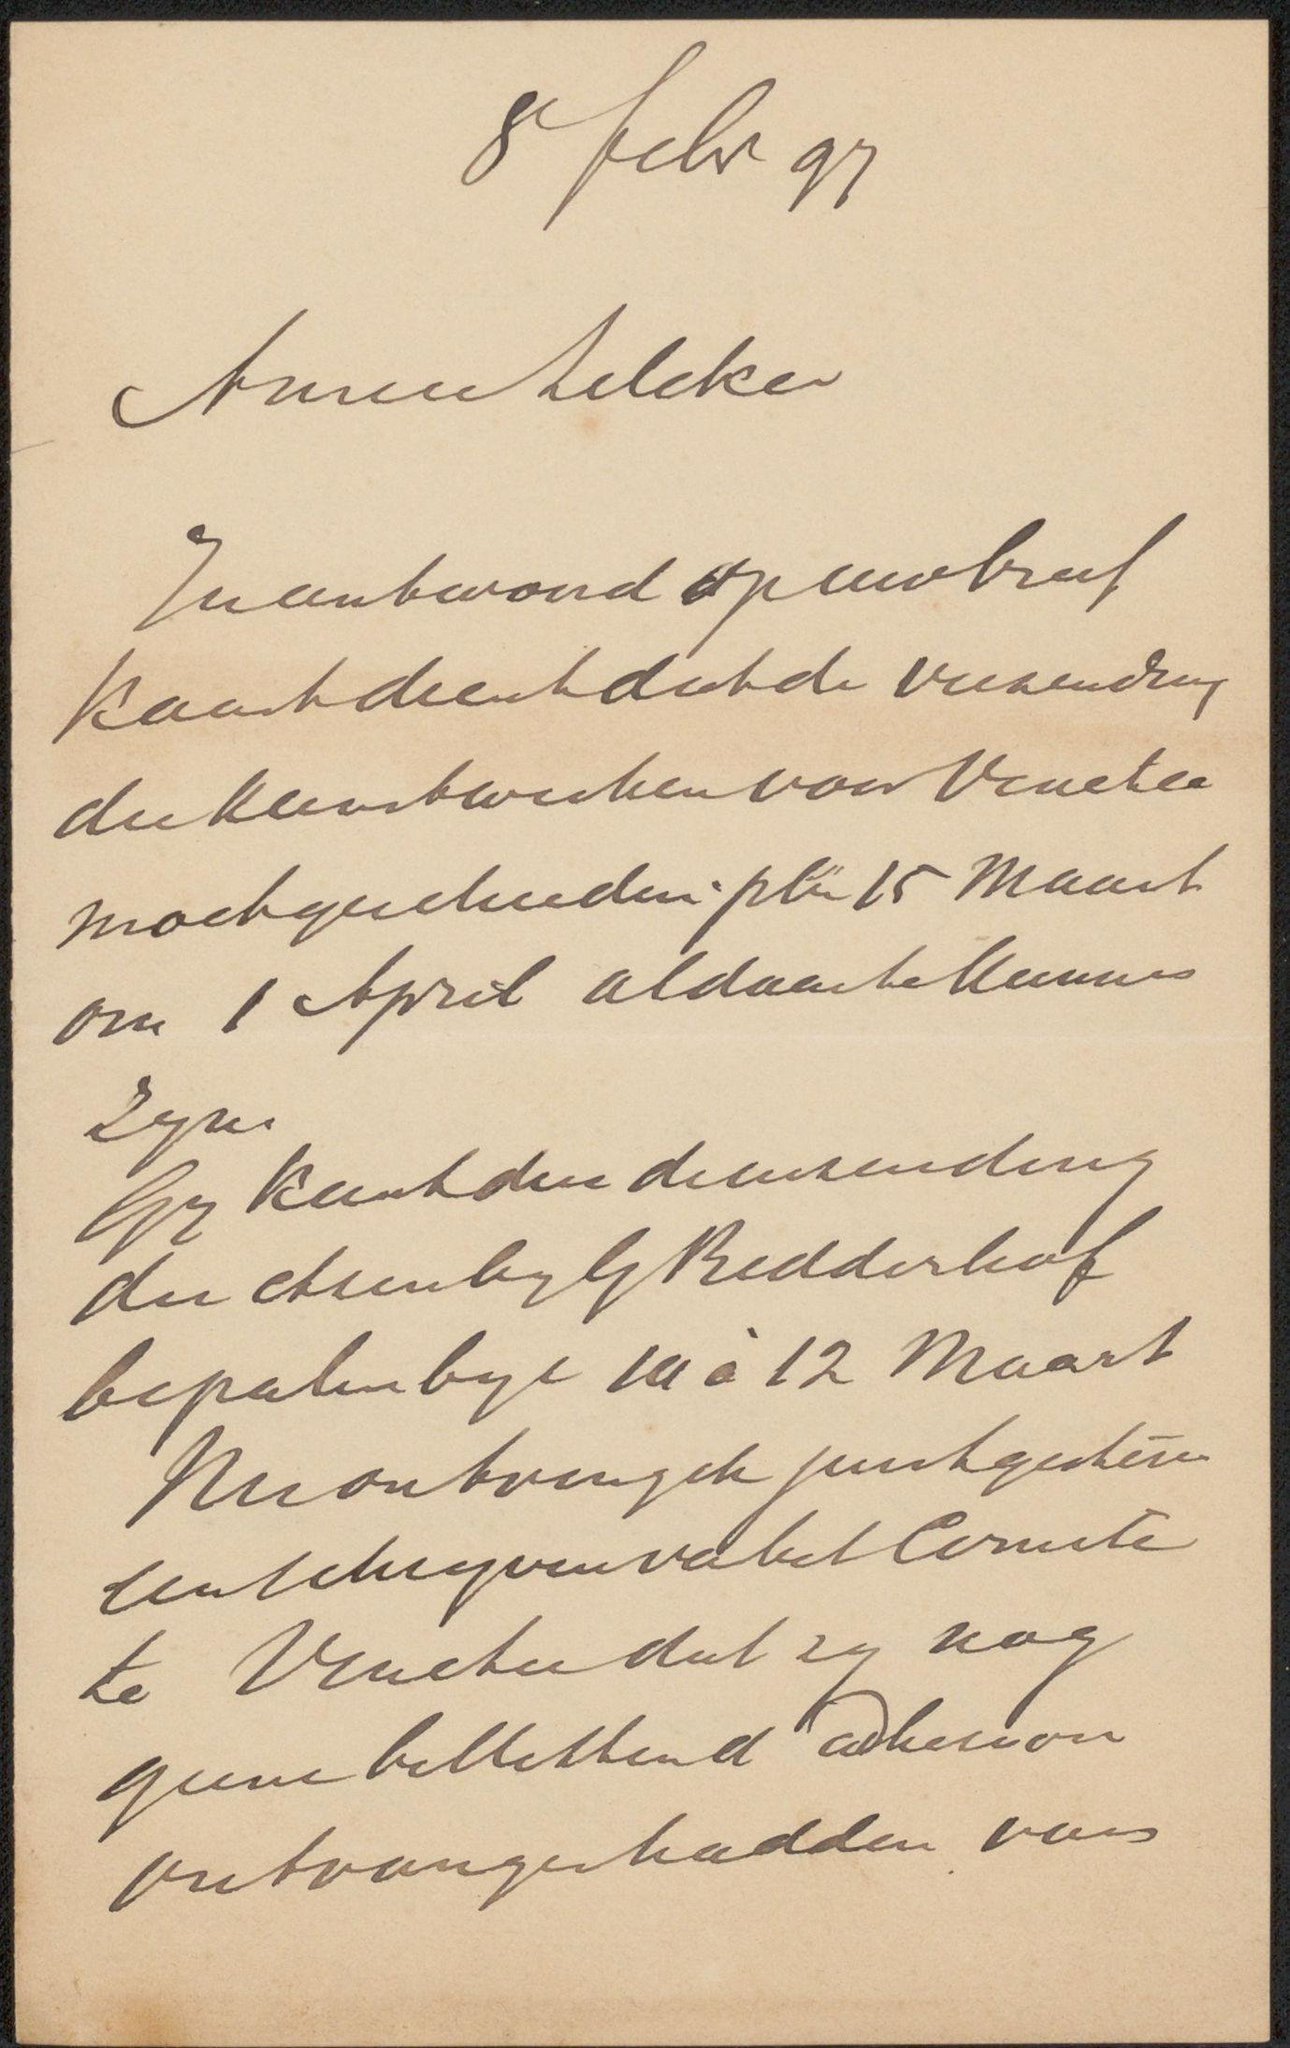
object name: letter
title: Brief aan Philip Zilcken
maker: hendrik willem mesdag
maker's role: draughtsman, painter, print maker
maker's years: 1831-1915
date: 1897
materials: ink, paper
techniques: pen, writing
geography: the hague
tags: rotterdam, george hendrik breitner, isaac israels, amsterdam, willem witsen, marius bauer, willem de zwart, jan toorop, the hague, painter, philip zilcken, the graphic arts, exhibition ~ art, printed matter, venice